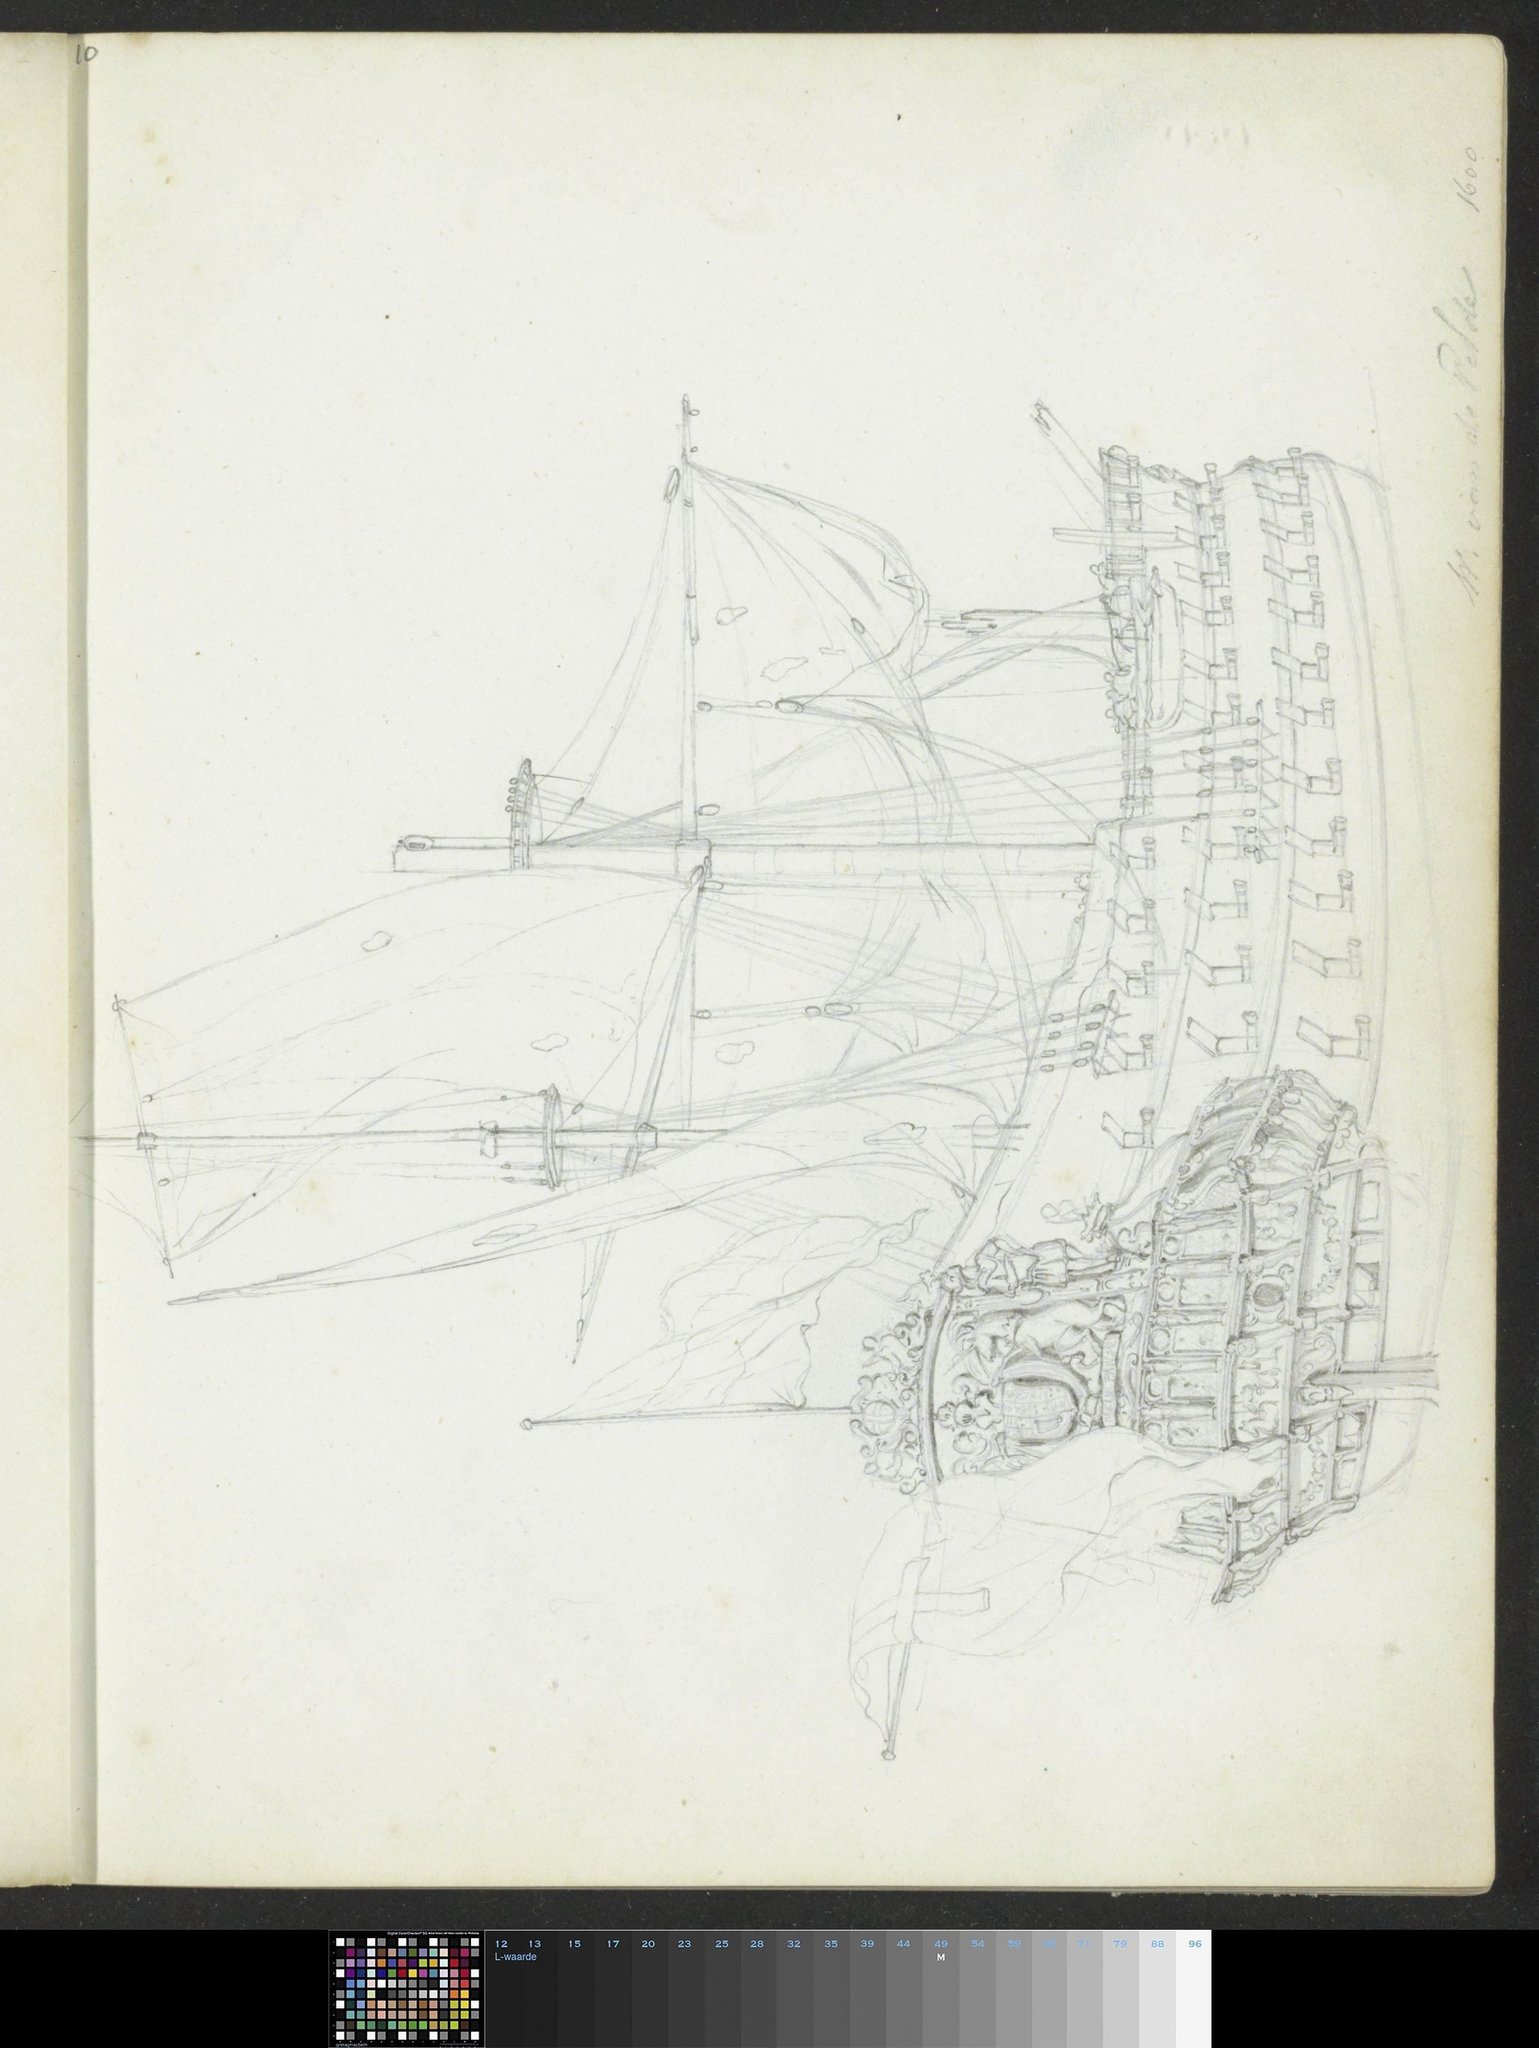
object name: sketchbook leaf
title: Zeilschip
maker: hendrik abraham klinkhamer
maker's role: draughtsman, painter, print maker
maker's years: 1810-1872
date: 1820-1872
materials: paper, pencil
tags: sailing-ship, sailing-boat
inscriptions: annotation: ‘W. van de Velde 1600’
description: Blad 10 recto uit een schetsboek met 21 bladen.